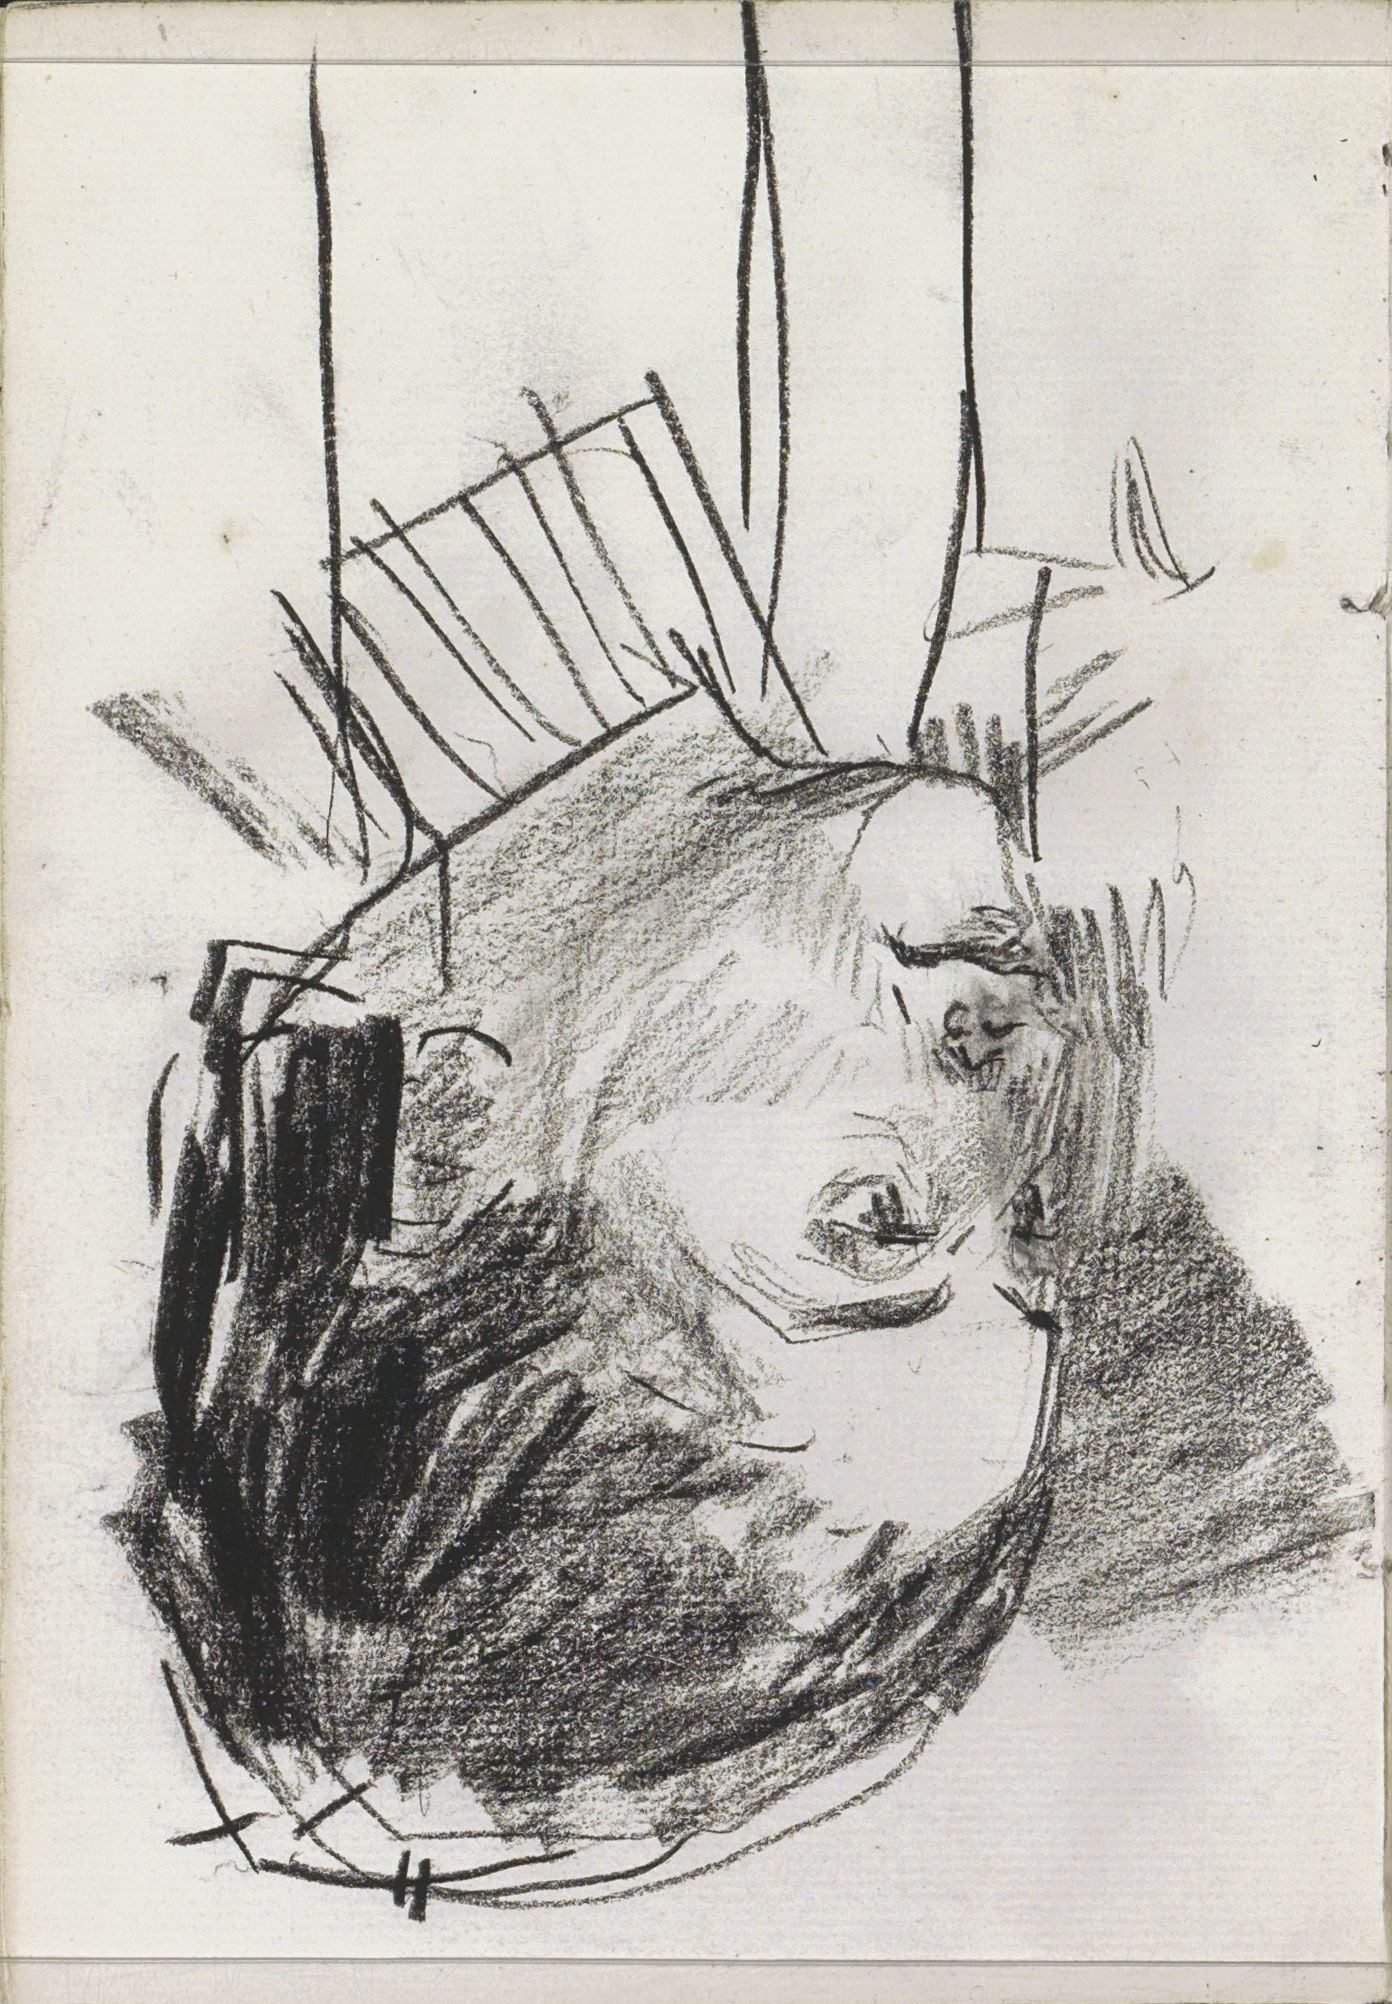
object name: sketchbook leaf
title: Vrouwenhoofd, in profiel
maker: isaac israels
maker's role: draughtsman, painter, print maker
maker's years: 1865-1934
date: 1875-1934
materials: chalk, paper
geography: the hague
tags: head (human) - aa - female human figure (+ sideview, profile)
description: Pagina 5 uit schetsboek XLIV met 43 pagina's.